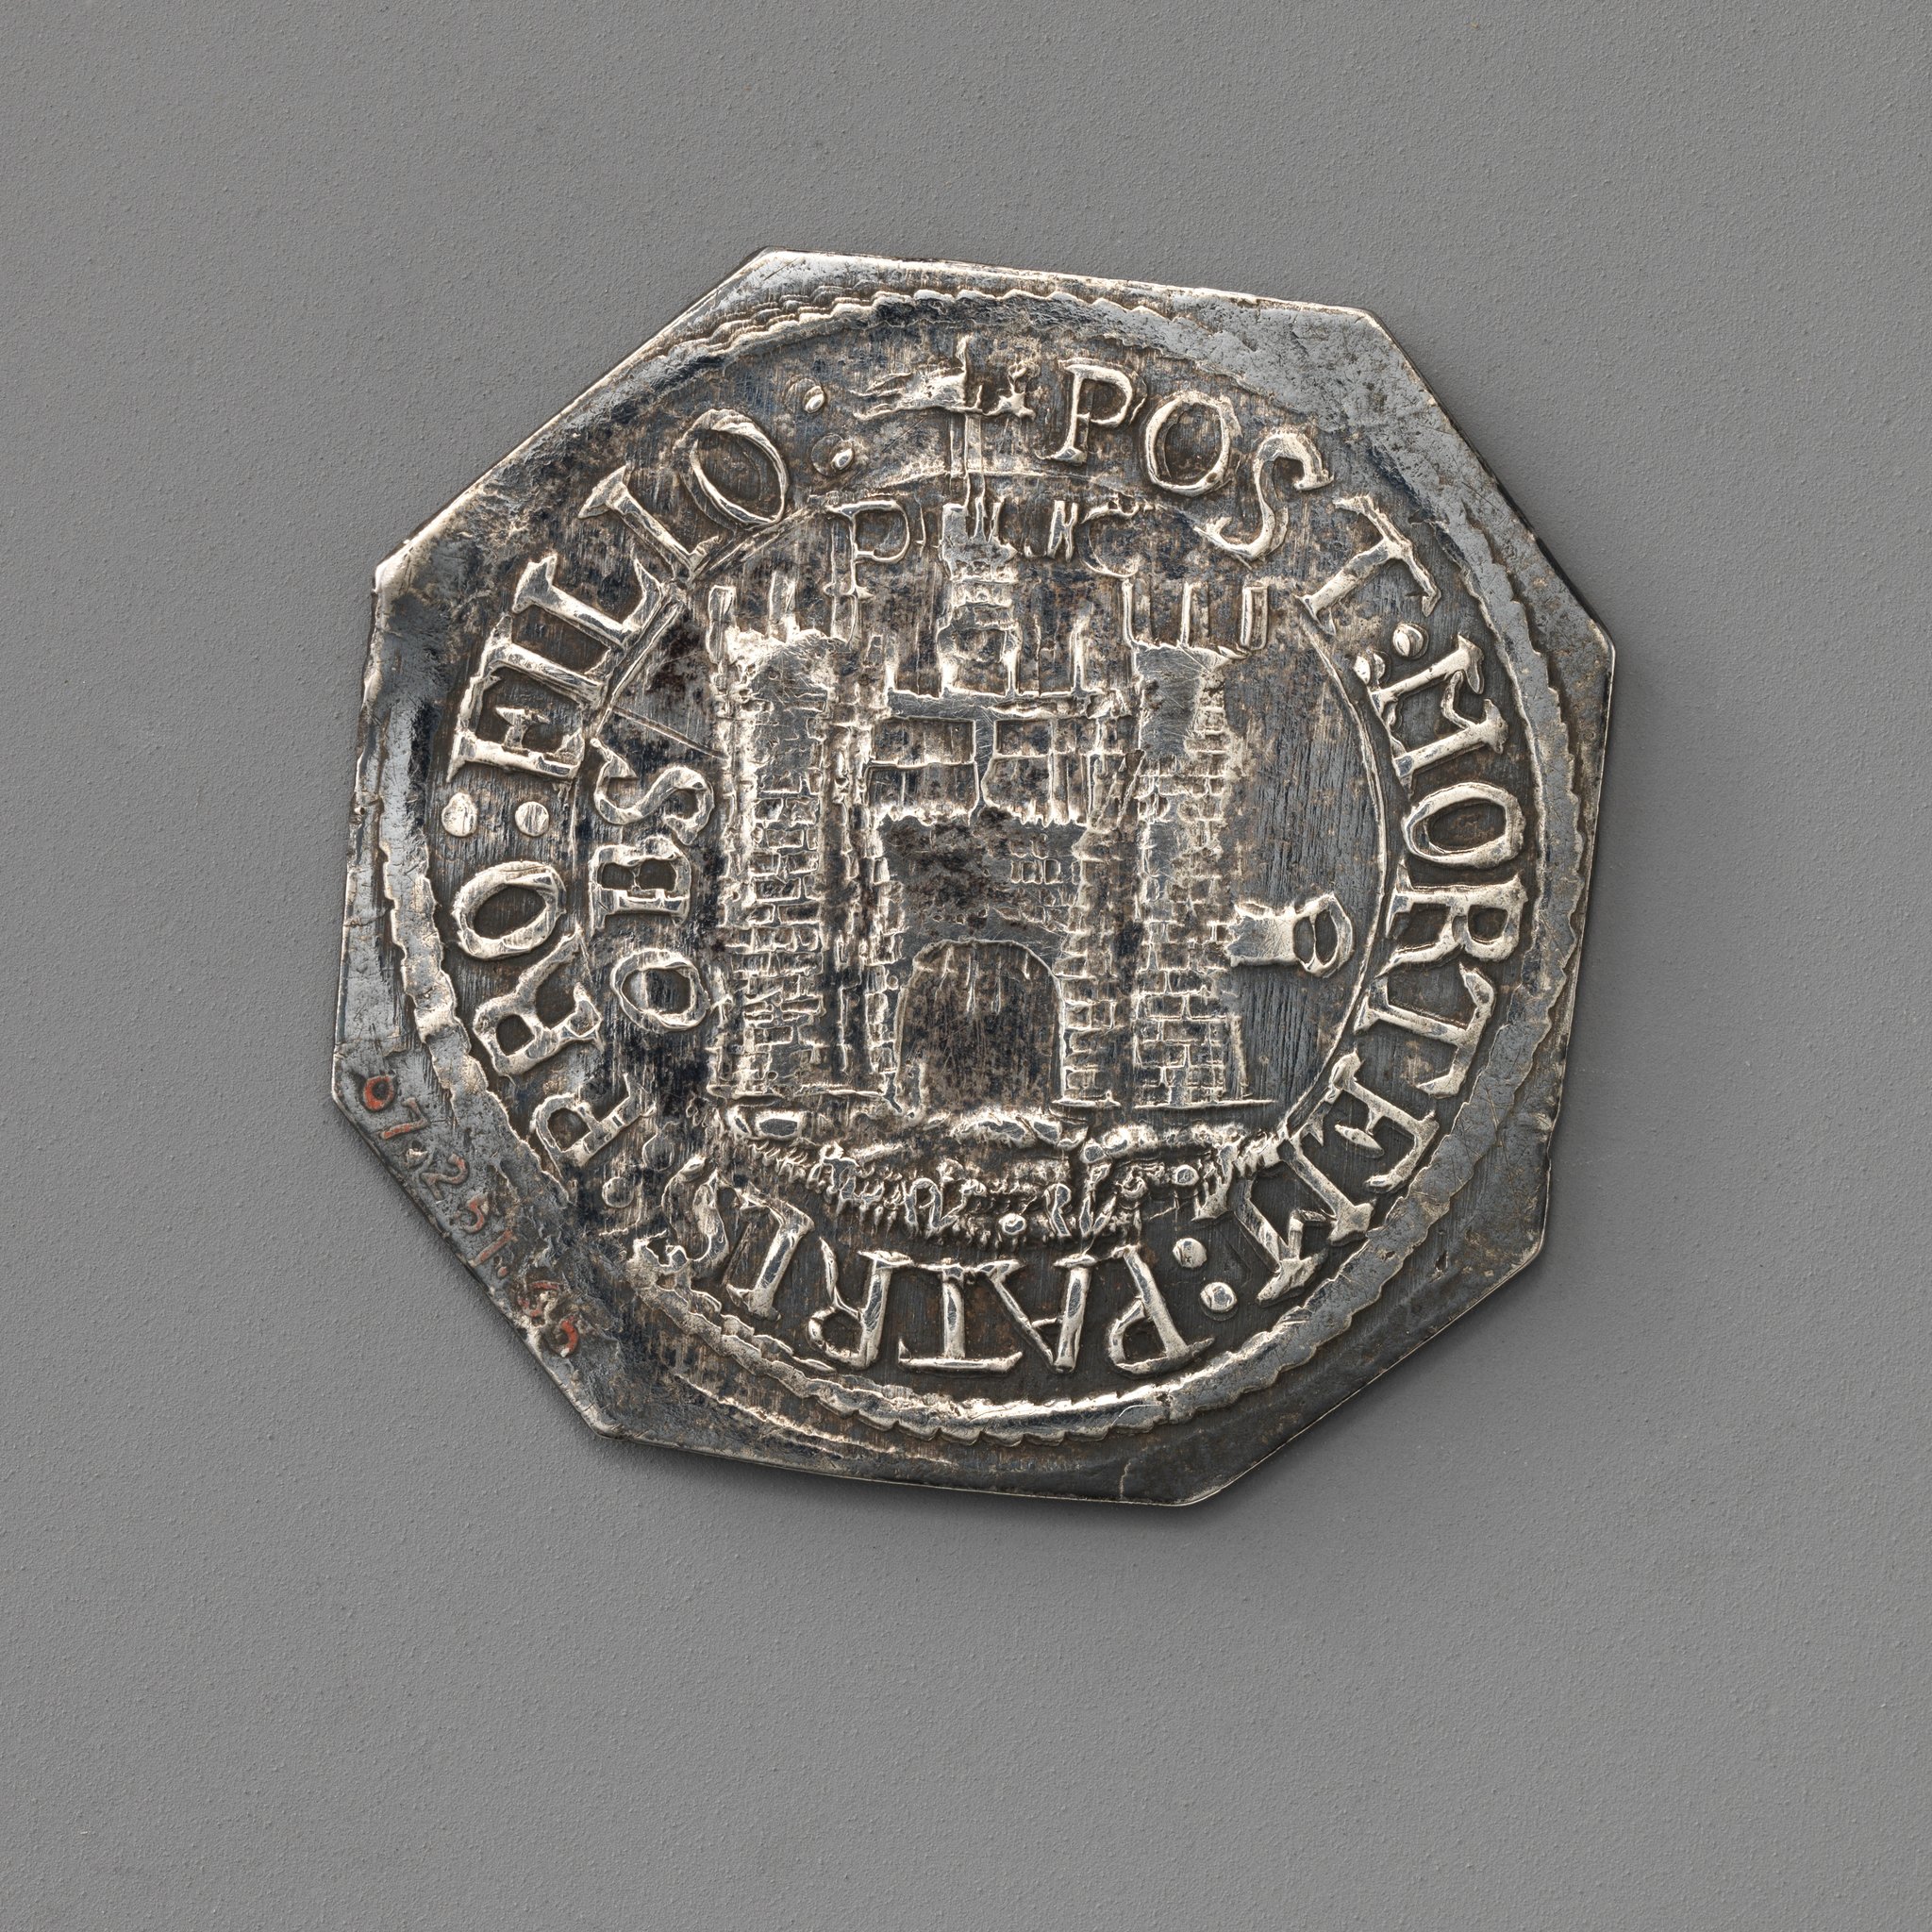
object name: coin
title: Pontefract Castle (Yorkshire), Charles II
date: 1648-1649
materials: silver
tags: castles